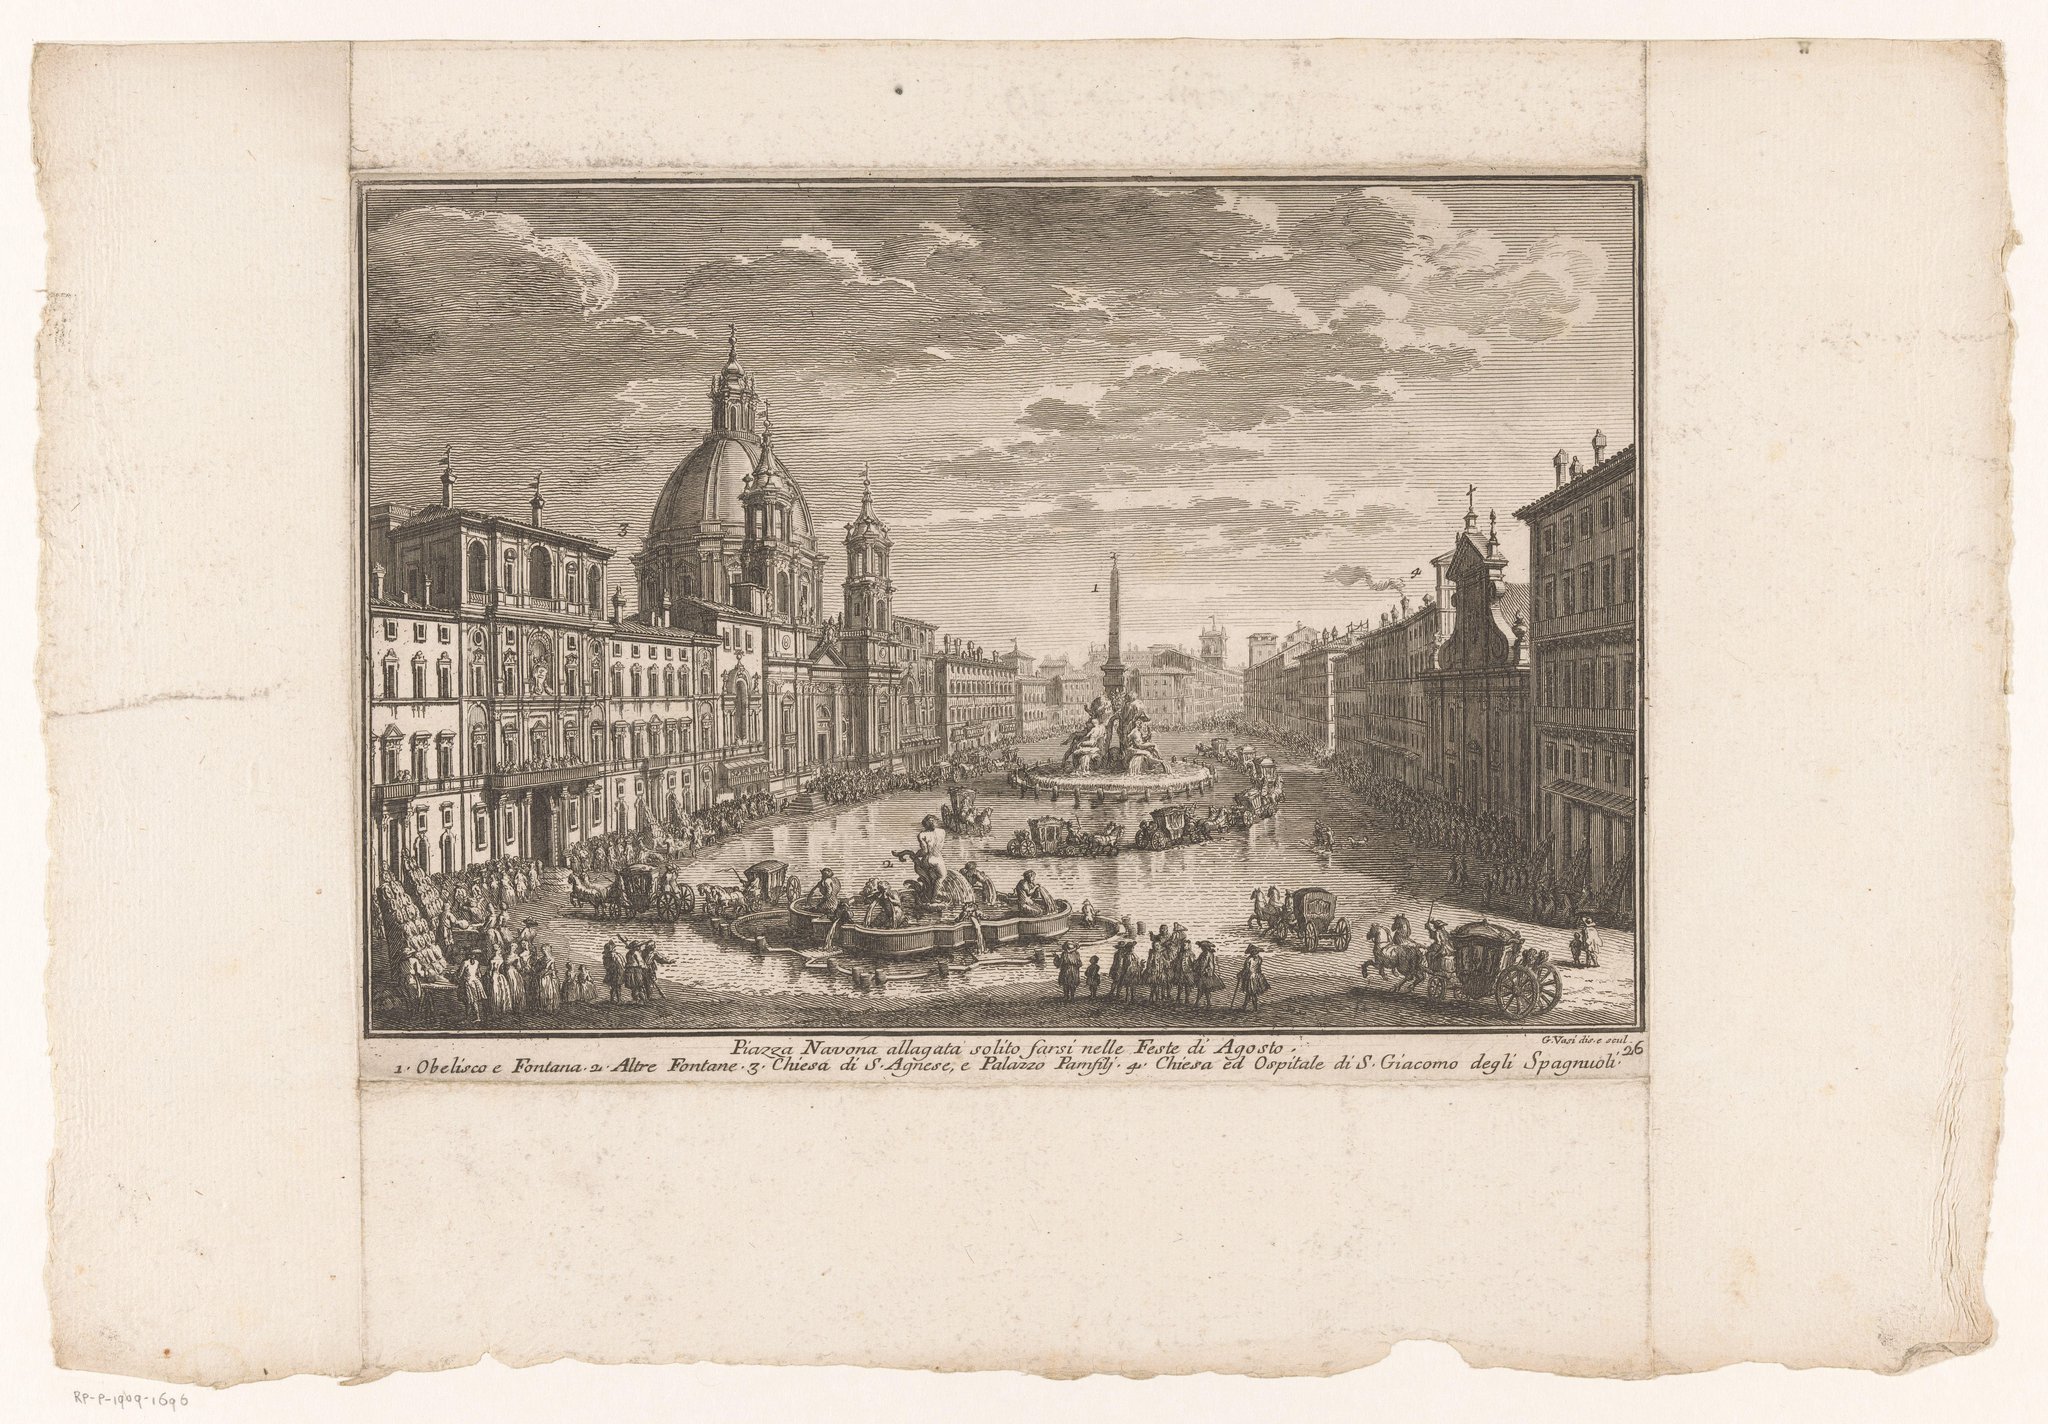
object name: print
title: Piazza Navona allagata solito farsi nelle Feste di Agosto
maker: giuseppe vasi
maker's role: draughtsman, painter, print maker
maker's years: 1710-1782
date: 1747-1761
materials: paper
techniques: etching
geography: italy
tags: square, place, circus, etc., obelisk, needle, city-view in general; 'veduta', roman catholic church, ornamental fountain, rome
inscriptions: collector's mark: Lugt 2228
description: Deze prent maakt deel uit van Giuseppe Vasi's serie gezichten op Rome, getiteld 'Delle Magnificenze di Roma Antica e Moderna'. De serie bestaat uit tien delen met elk twintig prenten en werd gepubliceerd tussen 1747 en 1761.